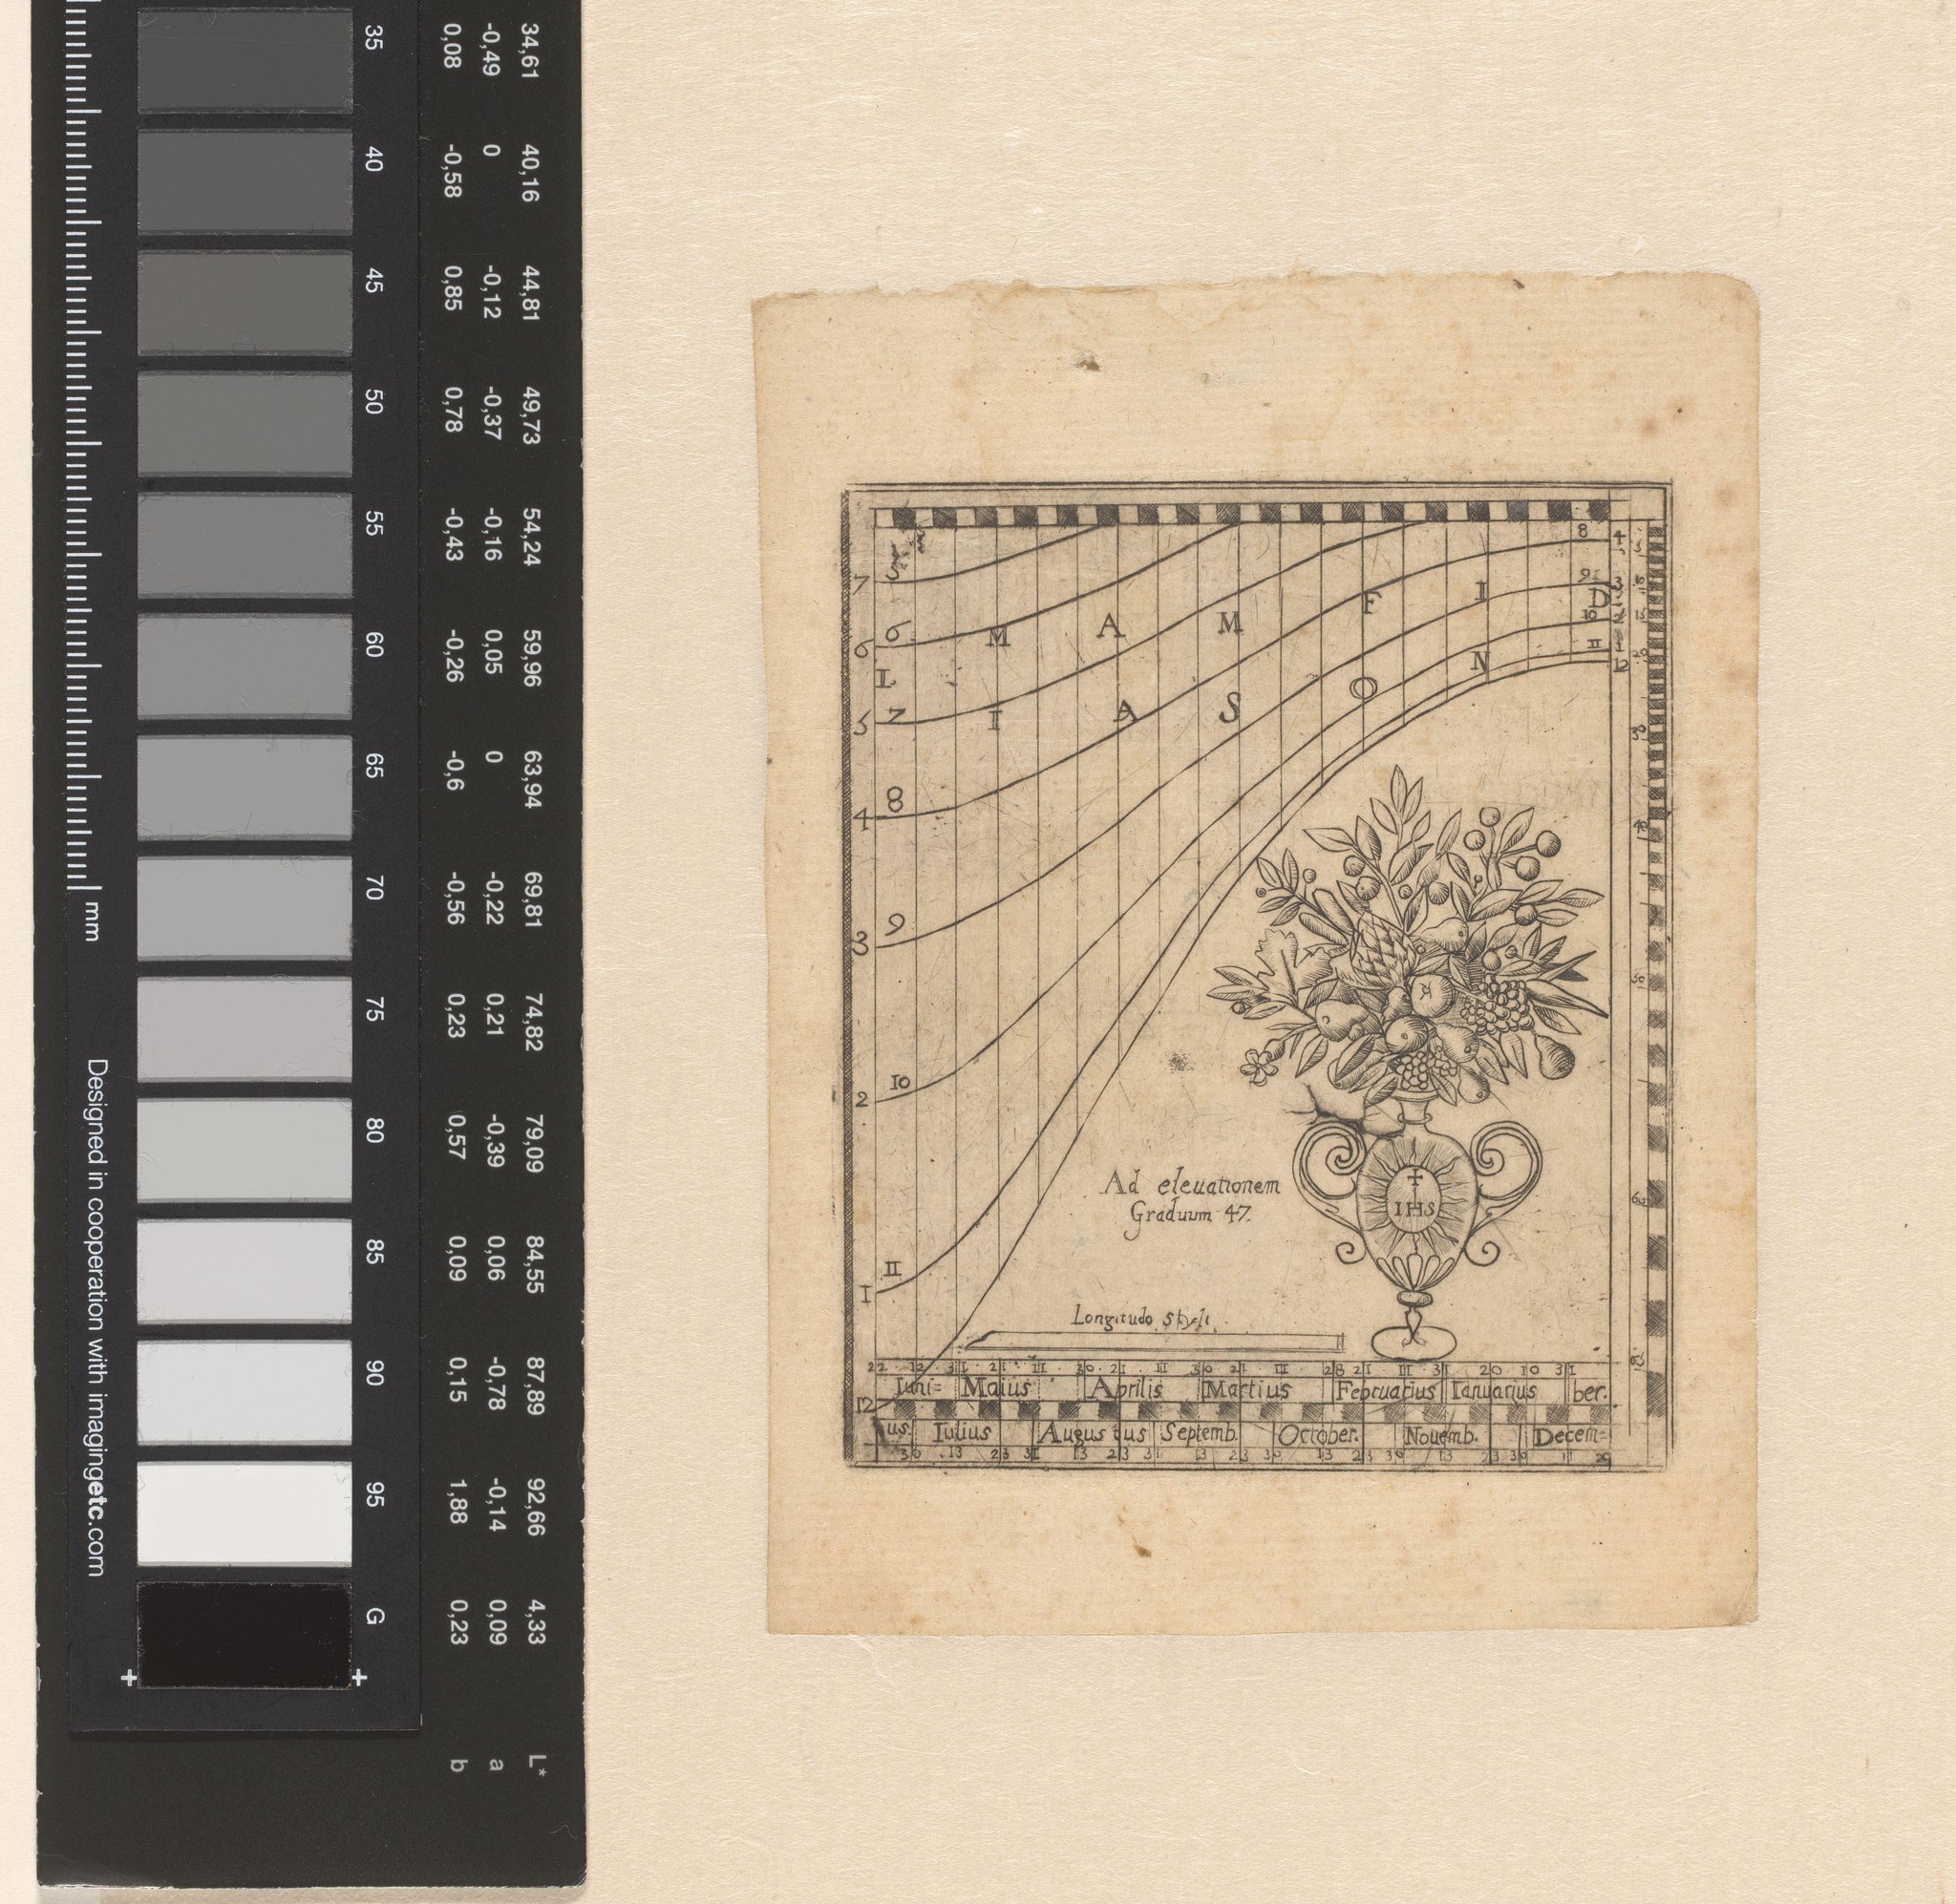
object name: print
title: Zonnewijzer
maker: Anonymous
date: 1575-1625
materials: paper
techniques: engraving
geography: italy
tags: flowers in a vase, sundial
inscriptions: collector's mark: Lugt 2760, collector's mark: Lugt 2228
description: Zonnewijzer met opschriften in het Italiaans. Vermoedelijk bedoeld om in een doosje te plakken voor mee op reis. Onderaan zijn de maanden en dagen aangegeven, daarboven de graden. Rechts is een vaas met daarop het Christus monogram en een boeket met bloemen. Een eenvoudiger versie van de gedrukte zonnewijzers zoals die werden geproduceerd door Duitse prentmakers waaronder Georg Brentl de Jonge.